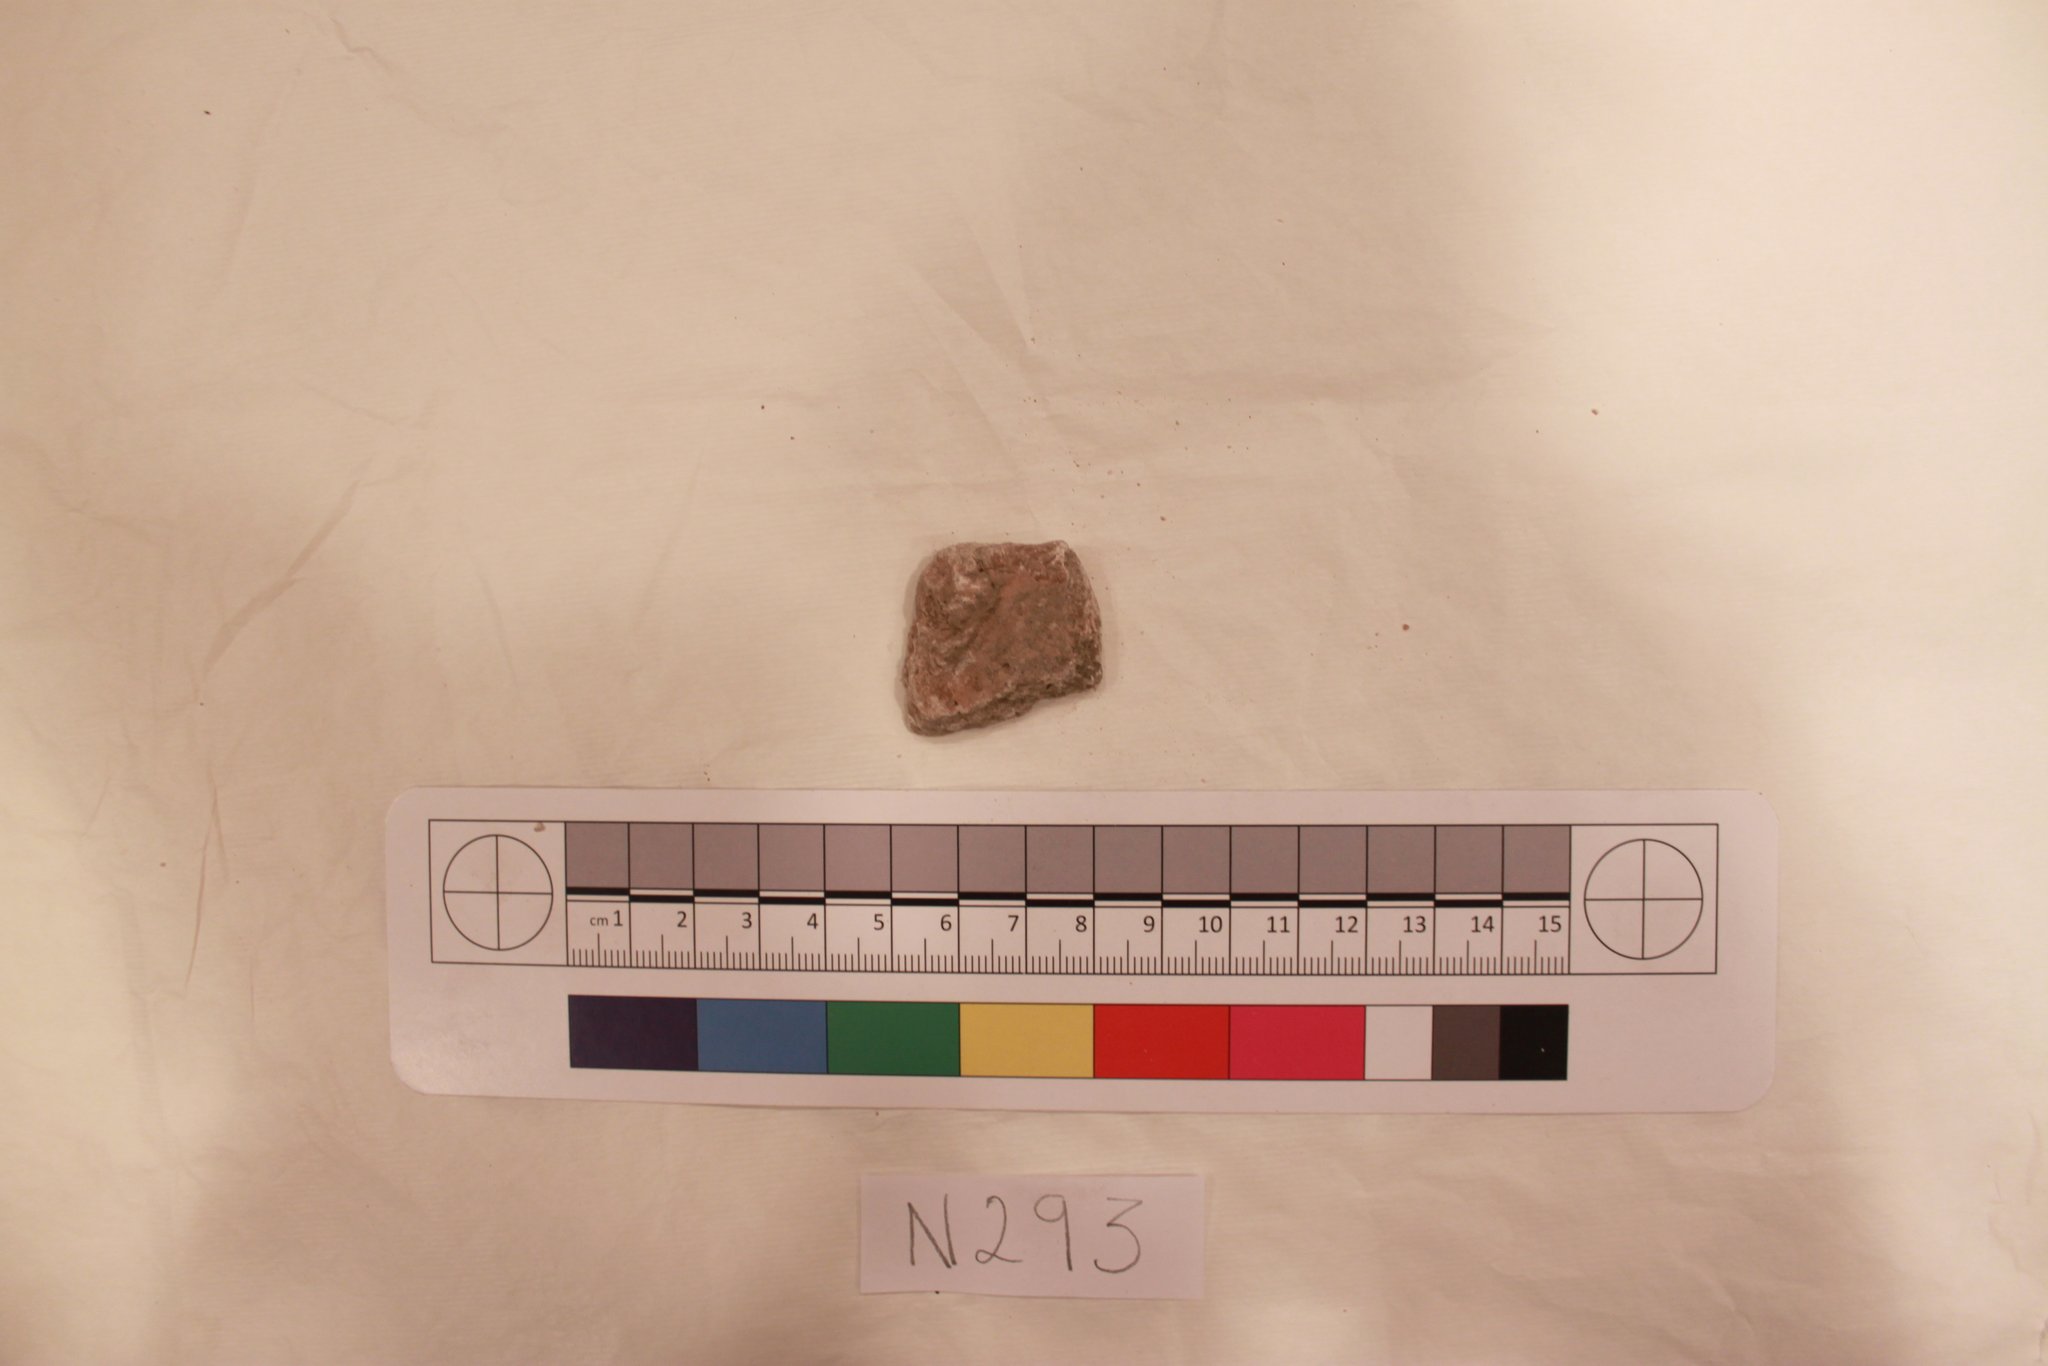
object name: fragment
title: Stucco Fragment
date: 701-1200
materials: plaster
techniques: carving, painting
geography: iran